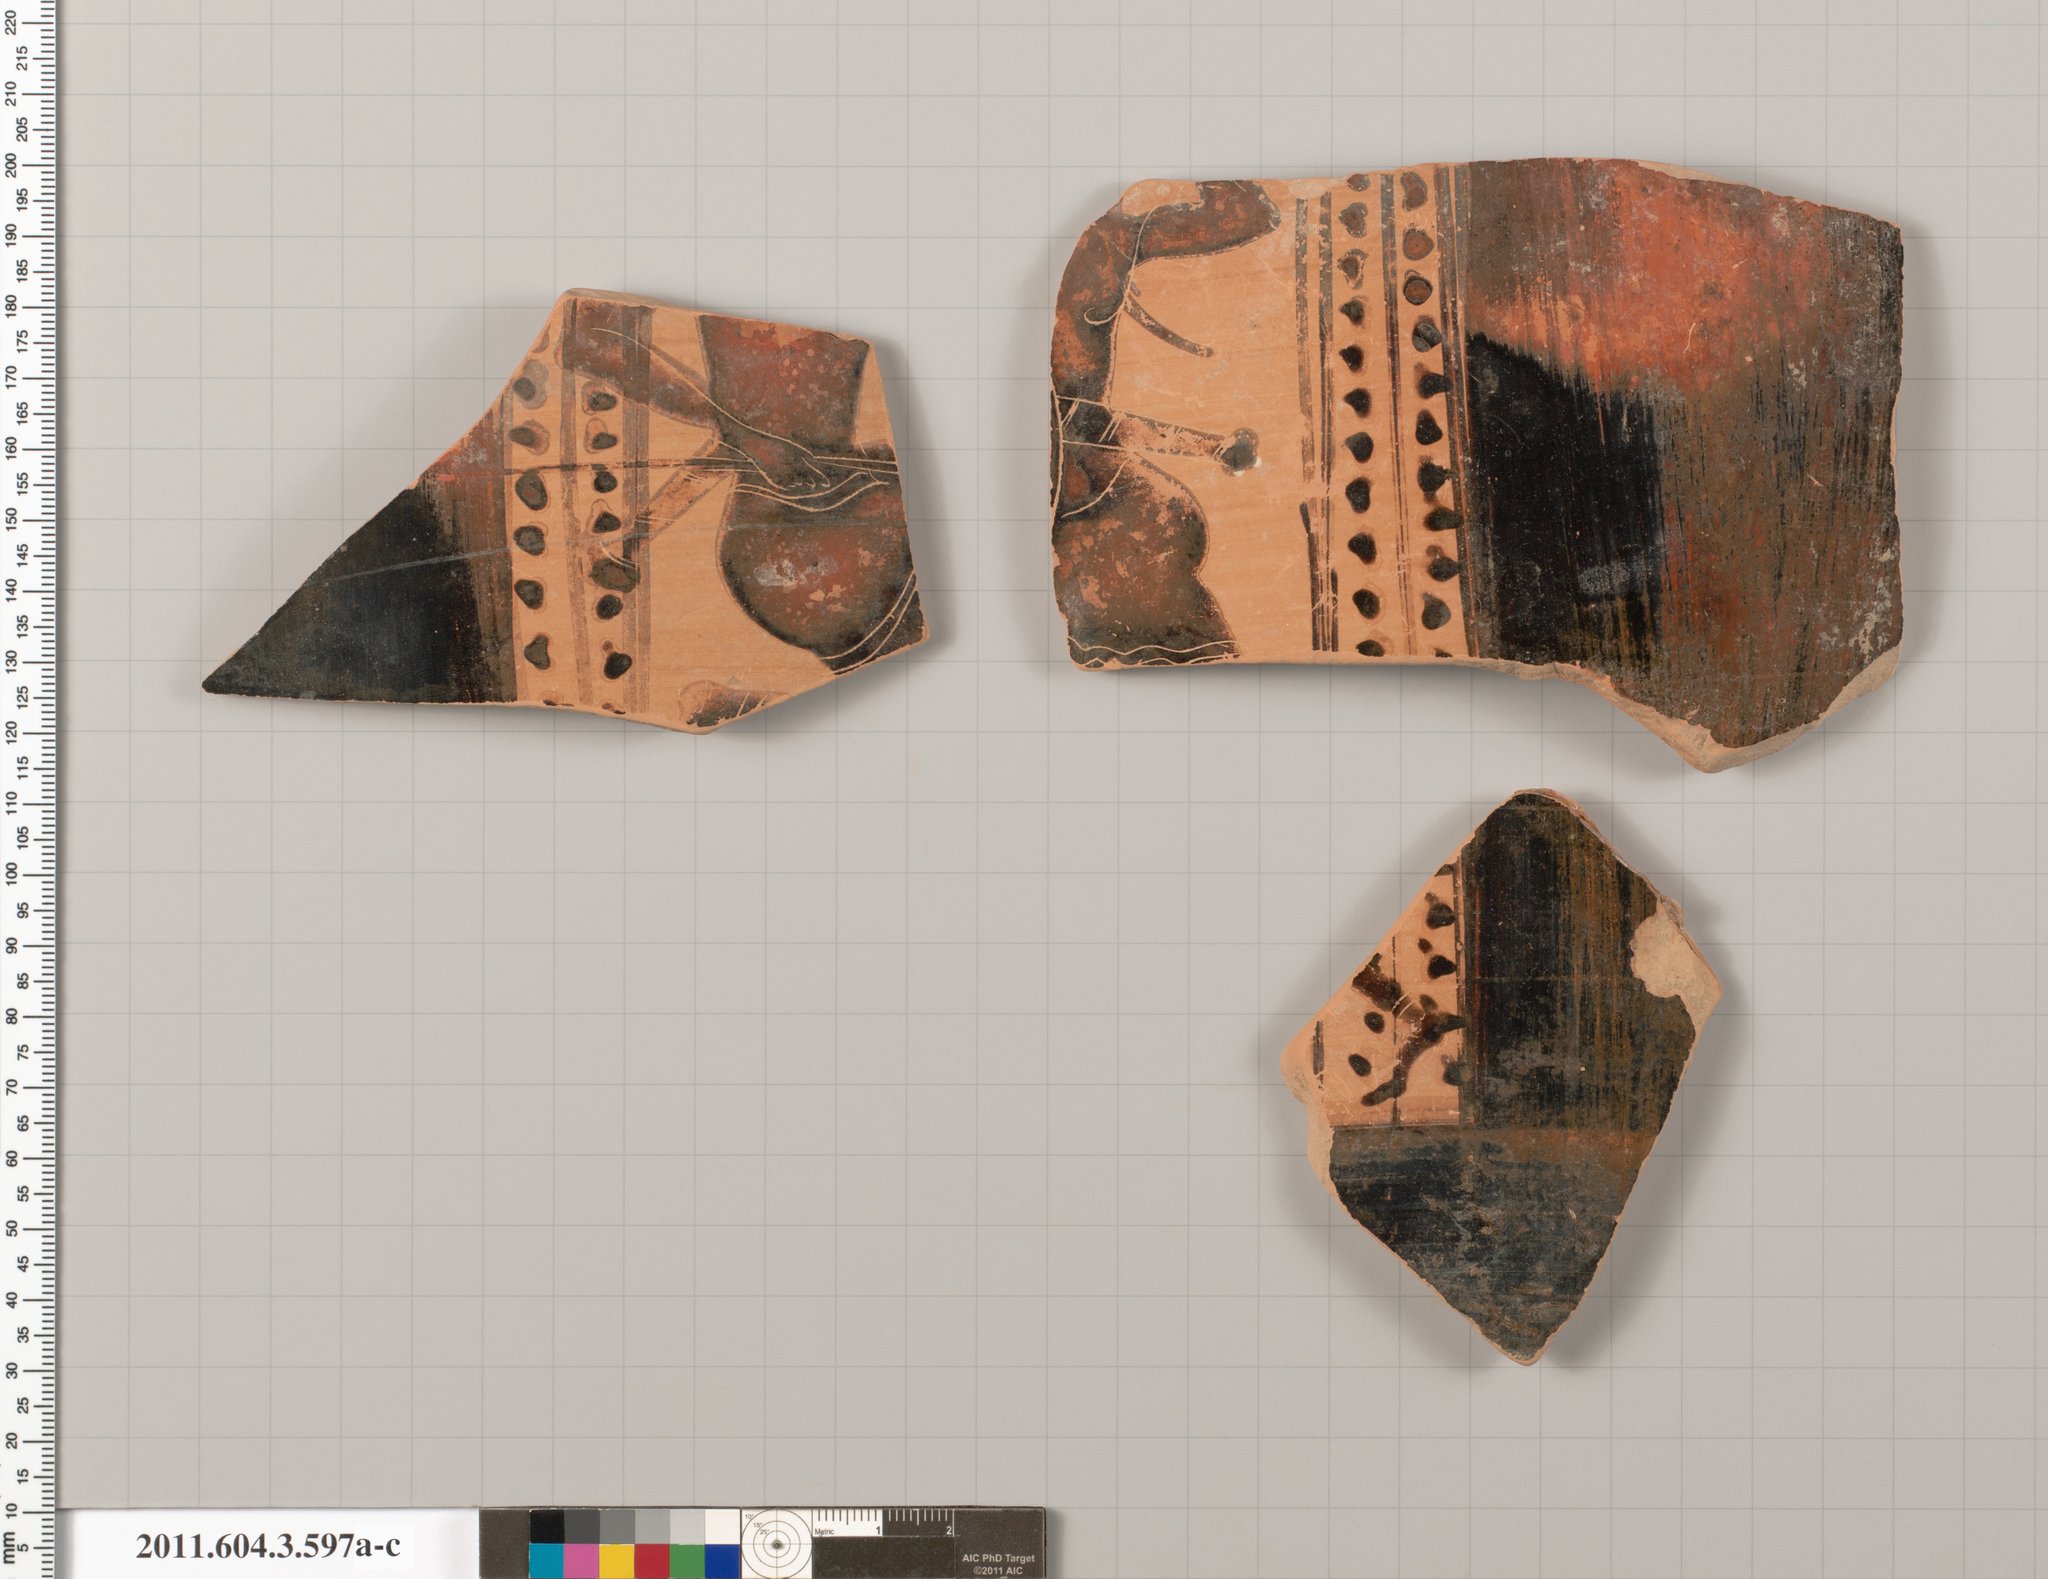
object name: column krater fragment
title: Terracotta fragments of a column-krater (bowl for mixing wine and water)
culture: greek, attic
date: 534-468 BCE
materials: terracotta